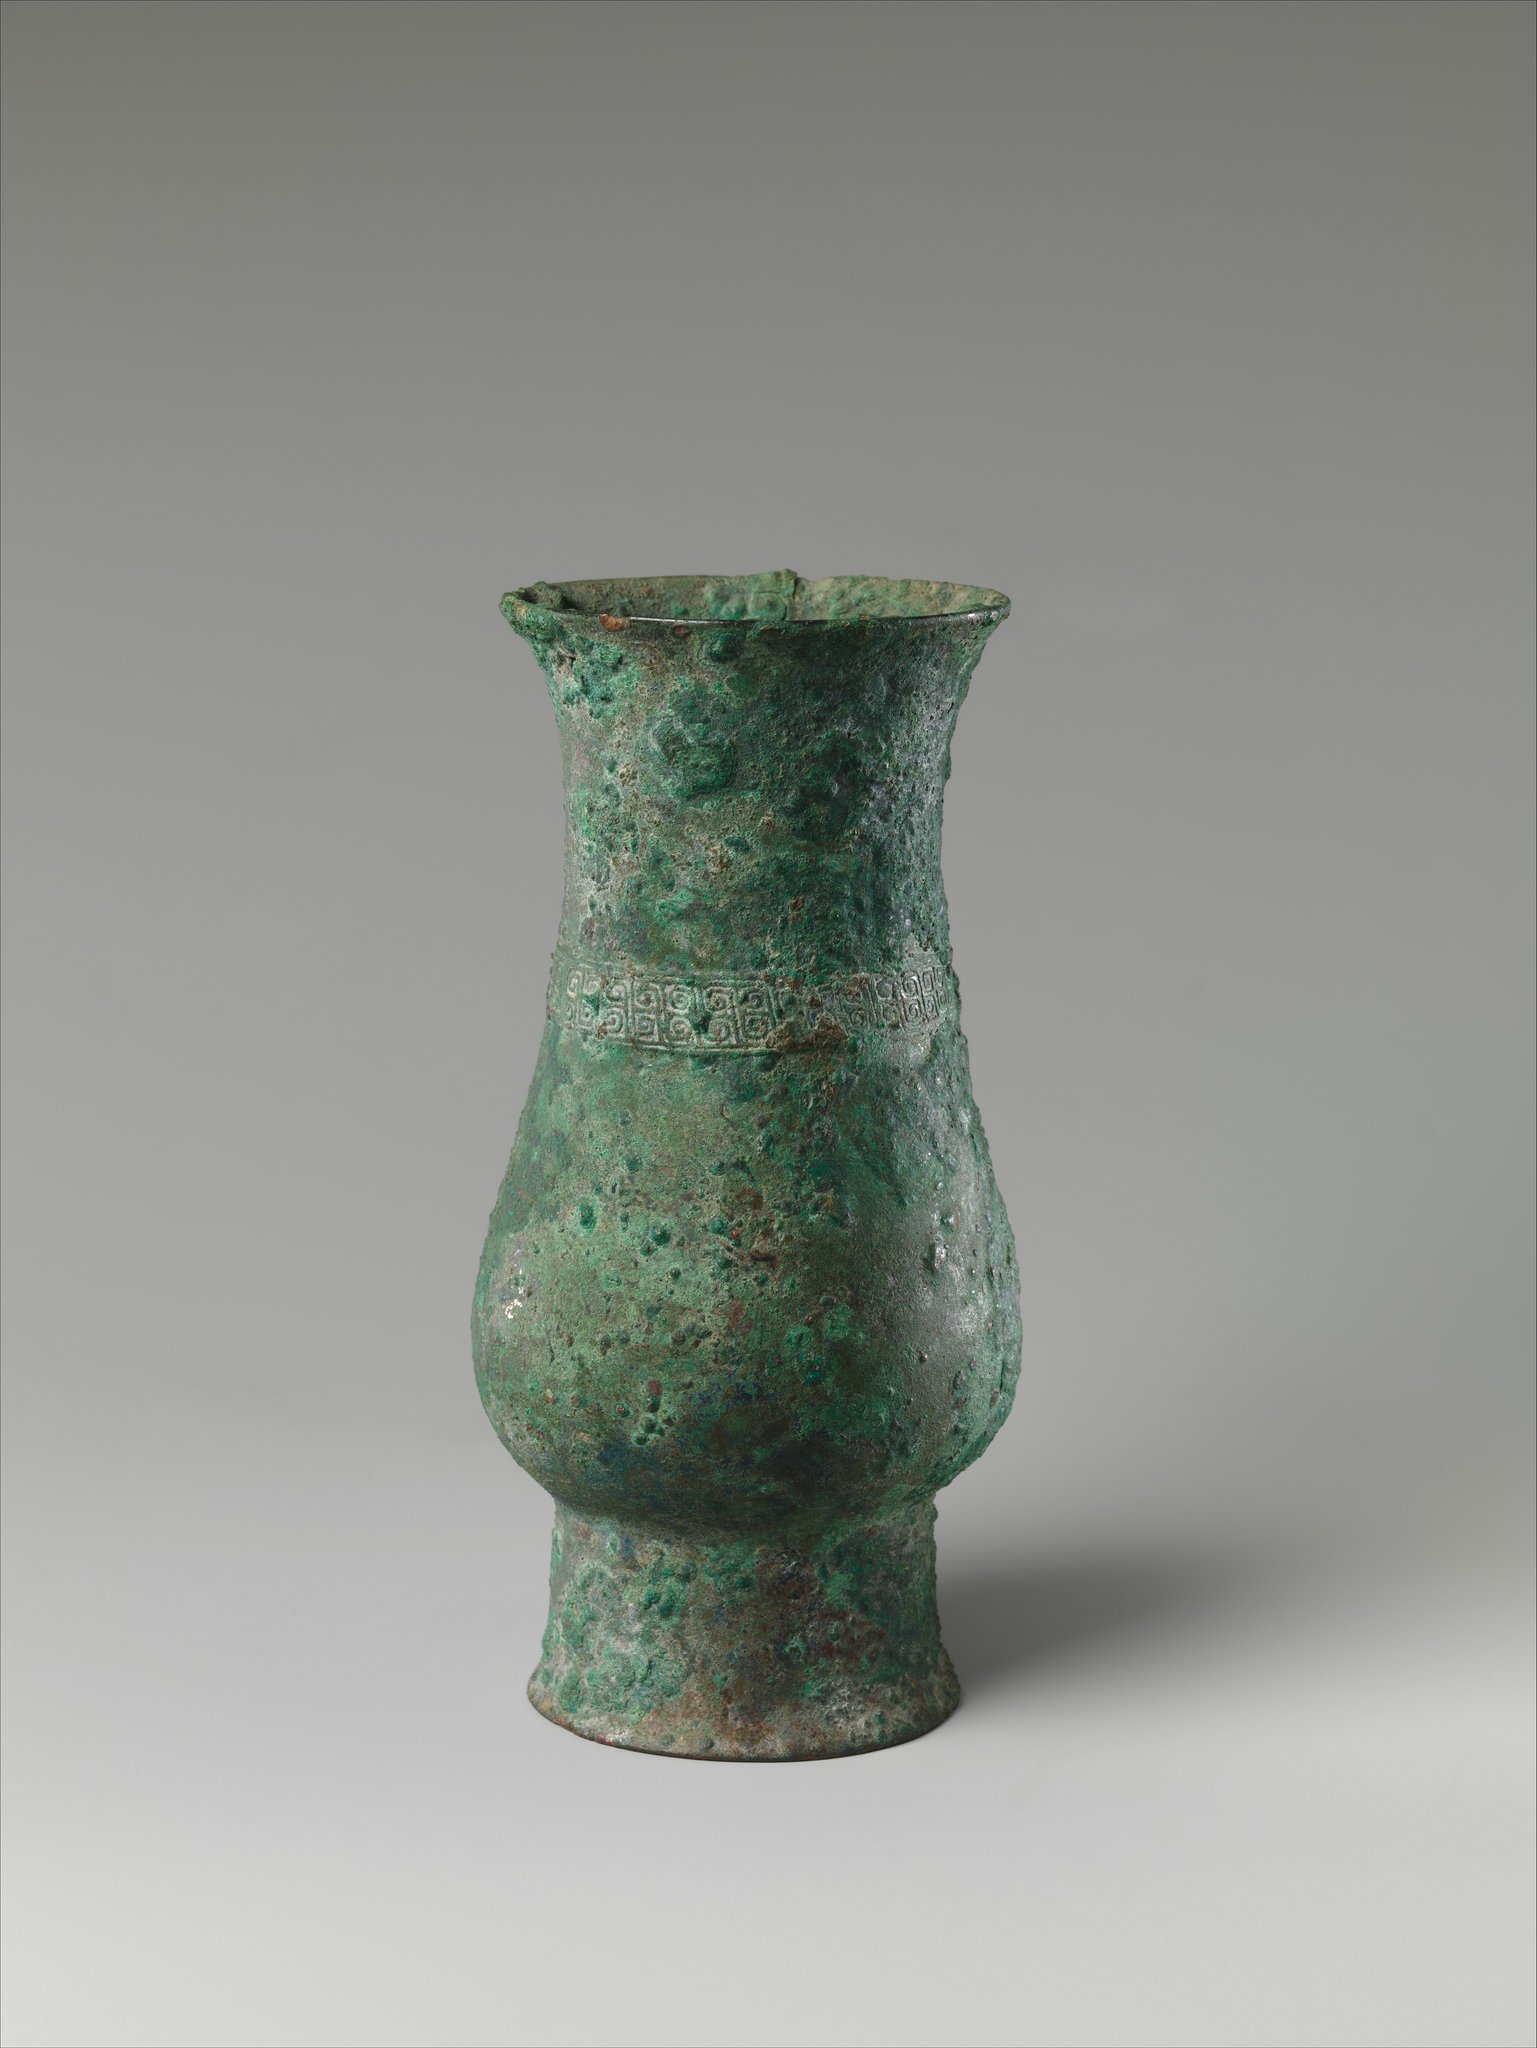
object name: wine cup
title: Ritual Wine Cup (Zhi)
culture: chinese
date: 1034-1001 BCE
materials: bronze